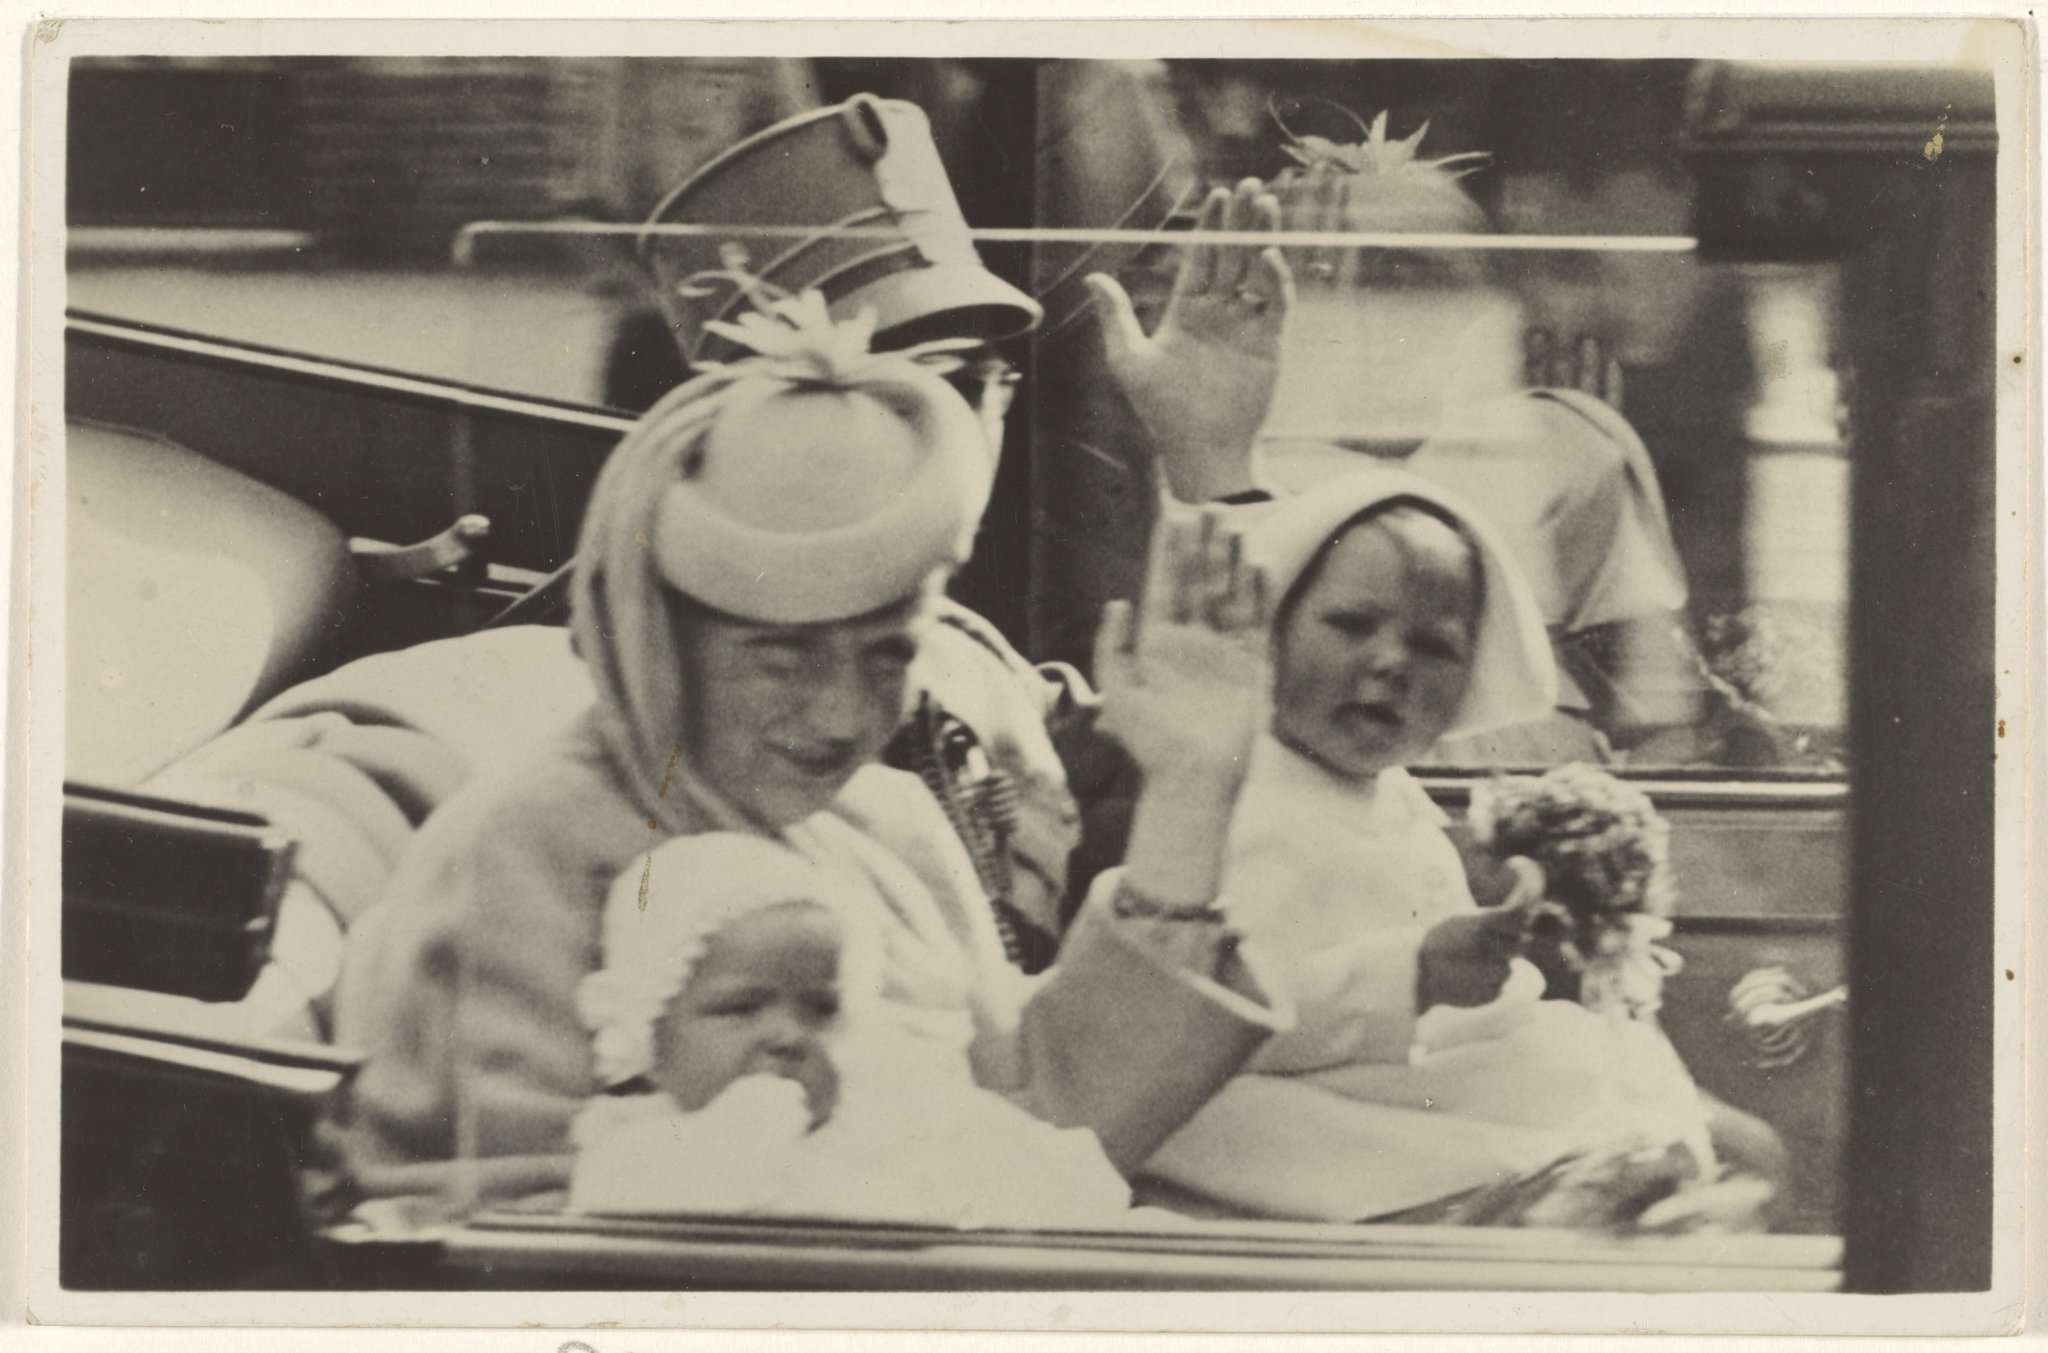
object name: photograph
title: Juliana, koningin der Nederlanden, Beatrix, koningin der Nederlanden, en Irene, prinses der Nederlanden, in een auto te Den Haag op de verjaardag van Juliana op 30 april 1940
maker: Anonymous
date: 1940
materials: photographic support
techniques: photography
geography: utrecht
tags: beatrix (koningin der nederlanden), juliana of the netherlands, the hague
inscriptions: date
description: De hier vermelde titel verwijst naar de hoogst verkregen titel van de geportretteerde, niet per se naar de titel die de geportretteerde op deze voorstelling draagt.